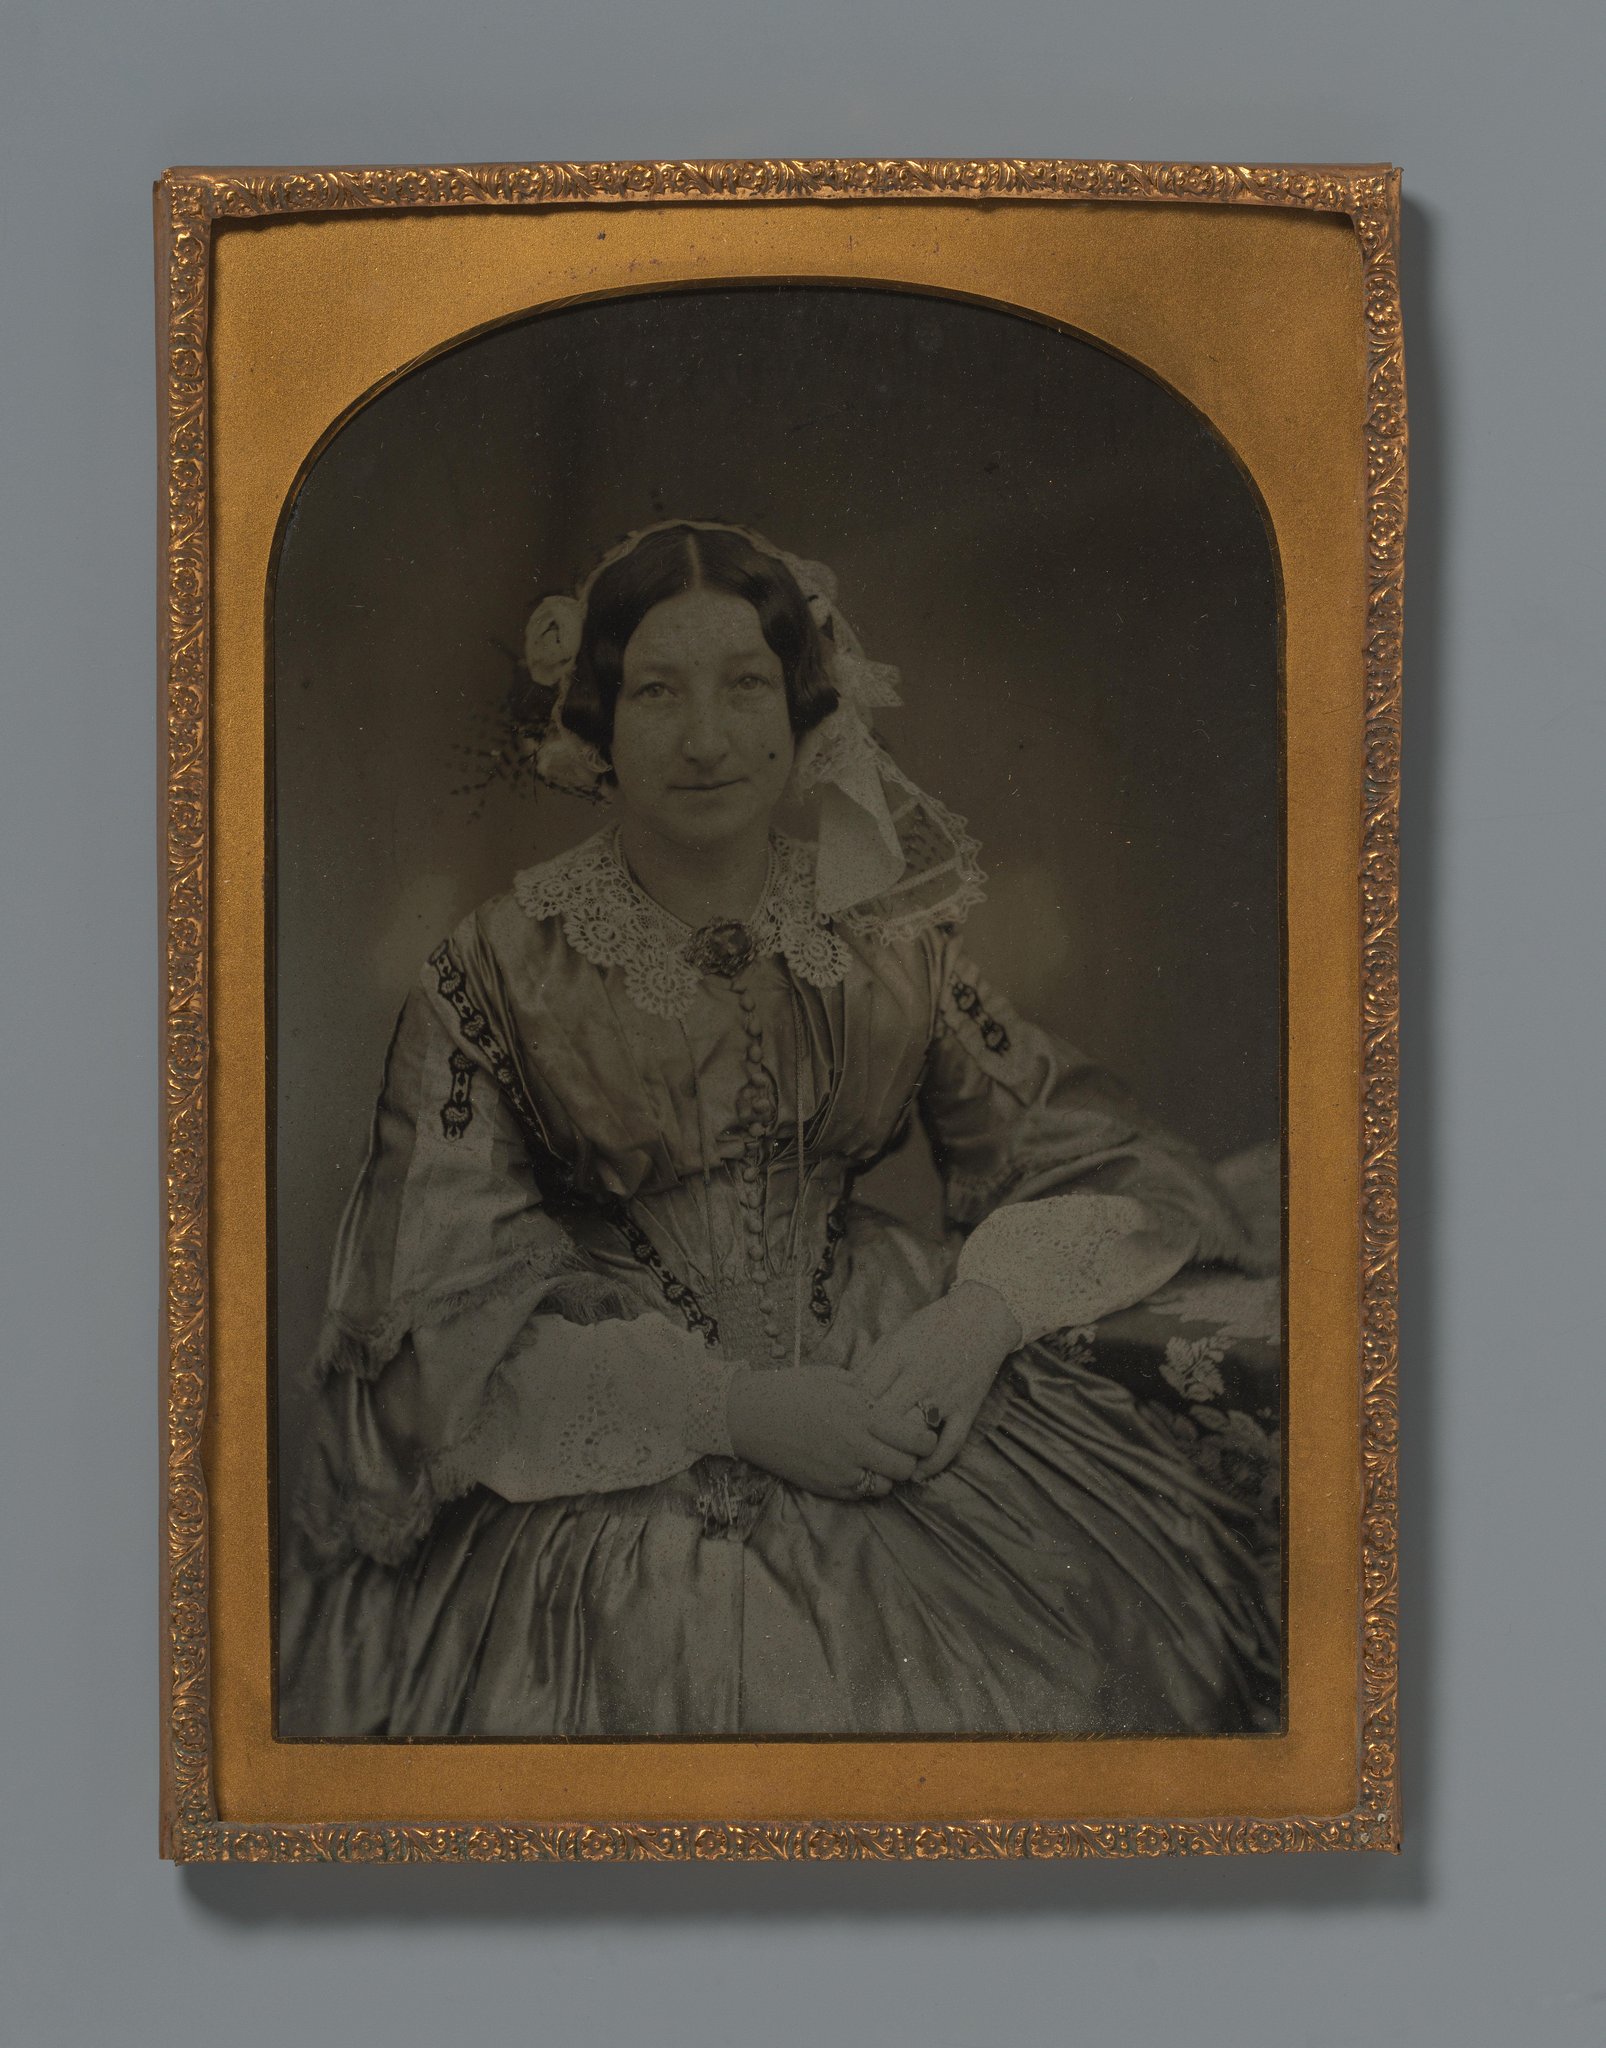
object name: photograph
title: Portret van een onbekende vrouw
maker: Anonymous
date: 1855-1870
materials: glass, metal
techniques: ambrotype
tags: sitting figure - aa - female human figure, historical persons - bb - woman